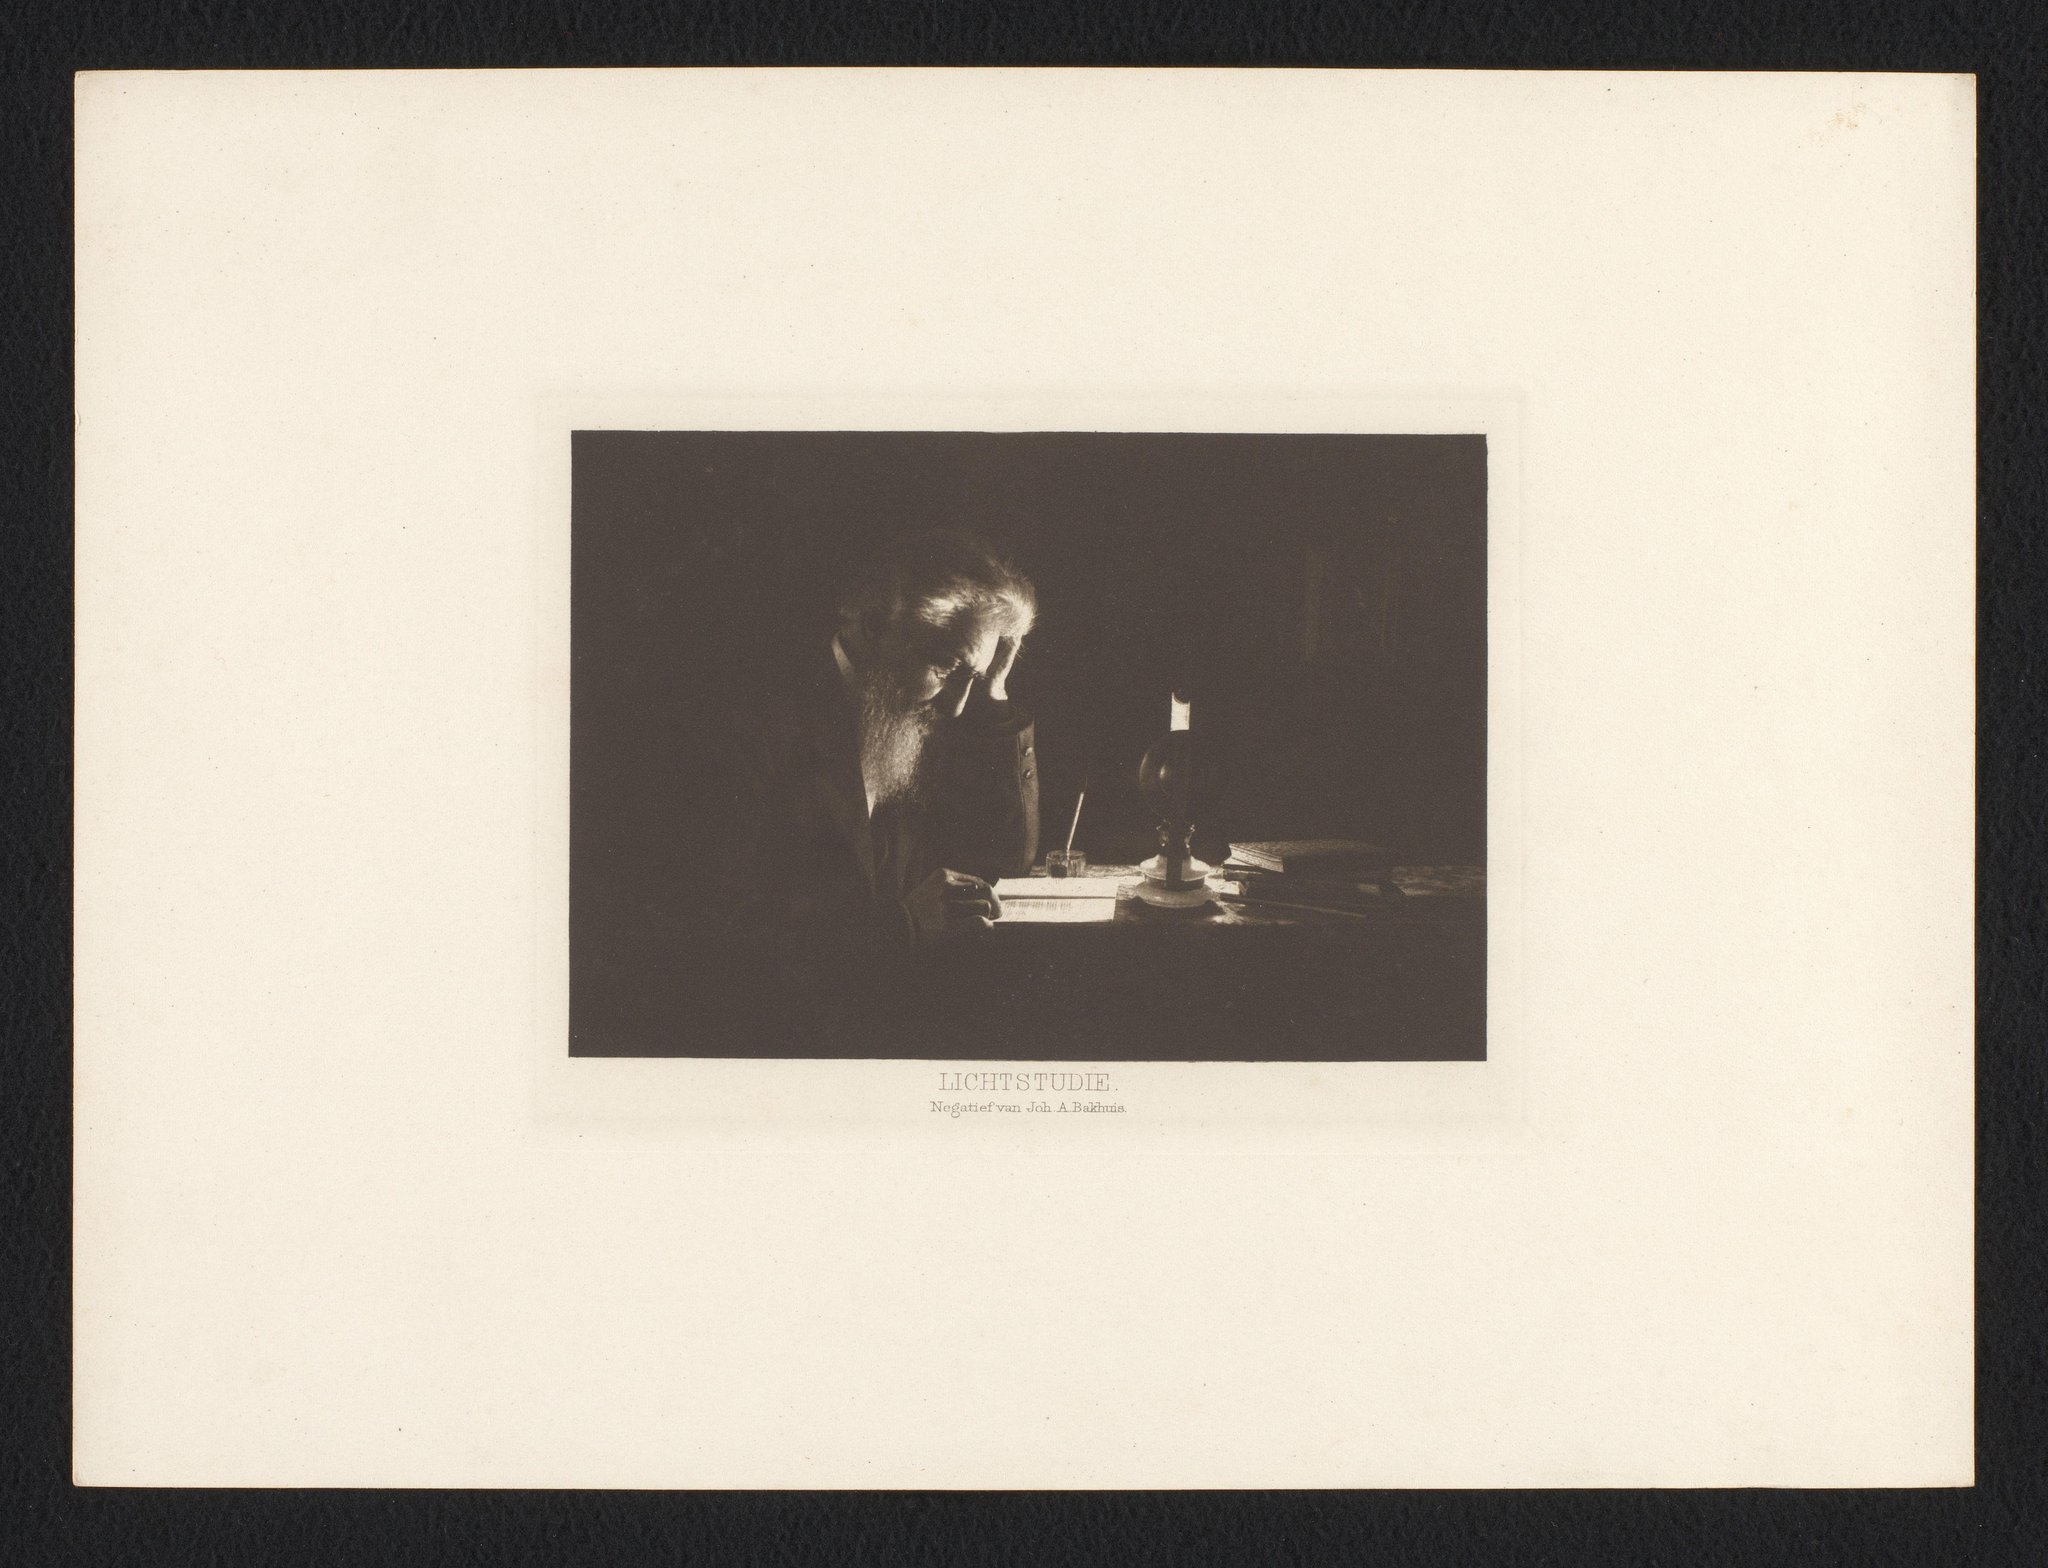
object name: page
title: Lichtstudie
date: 1899-1904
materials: paper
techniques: photoaquatint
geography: netherlands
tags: male sex; man, netherlands